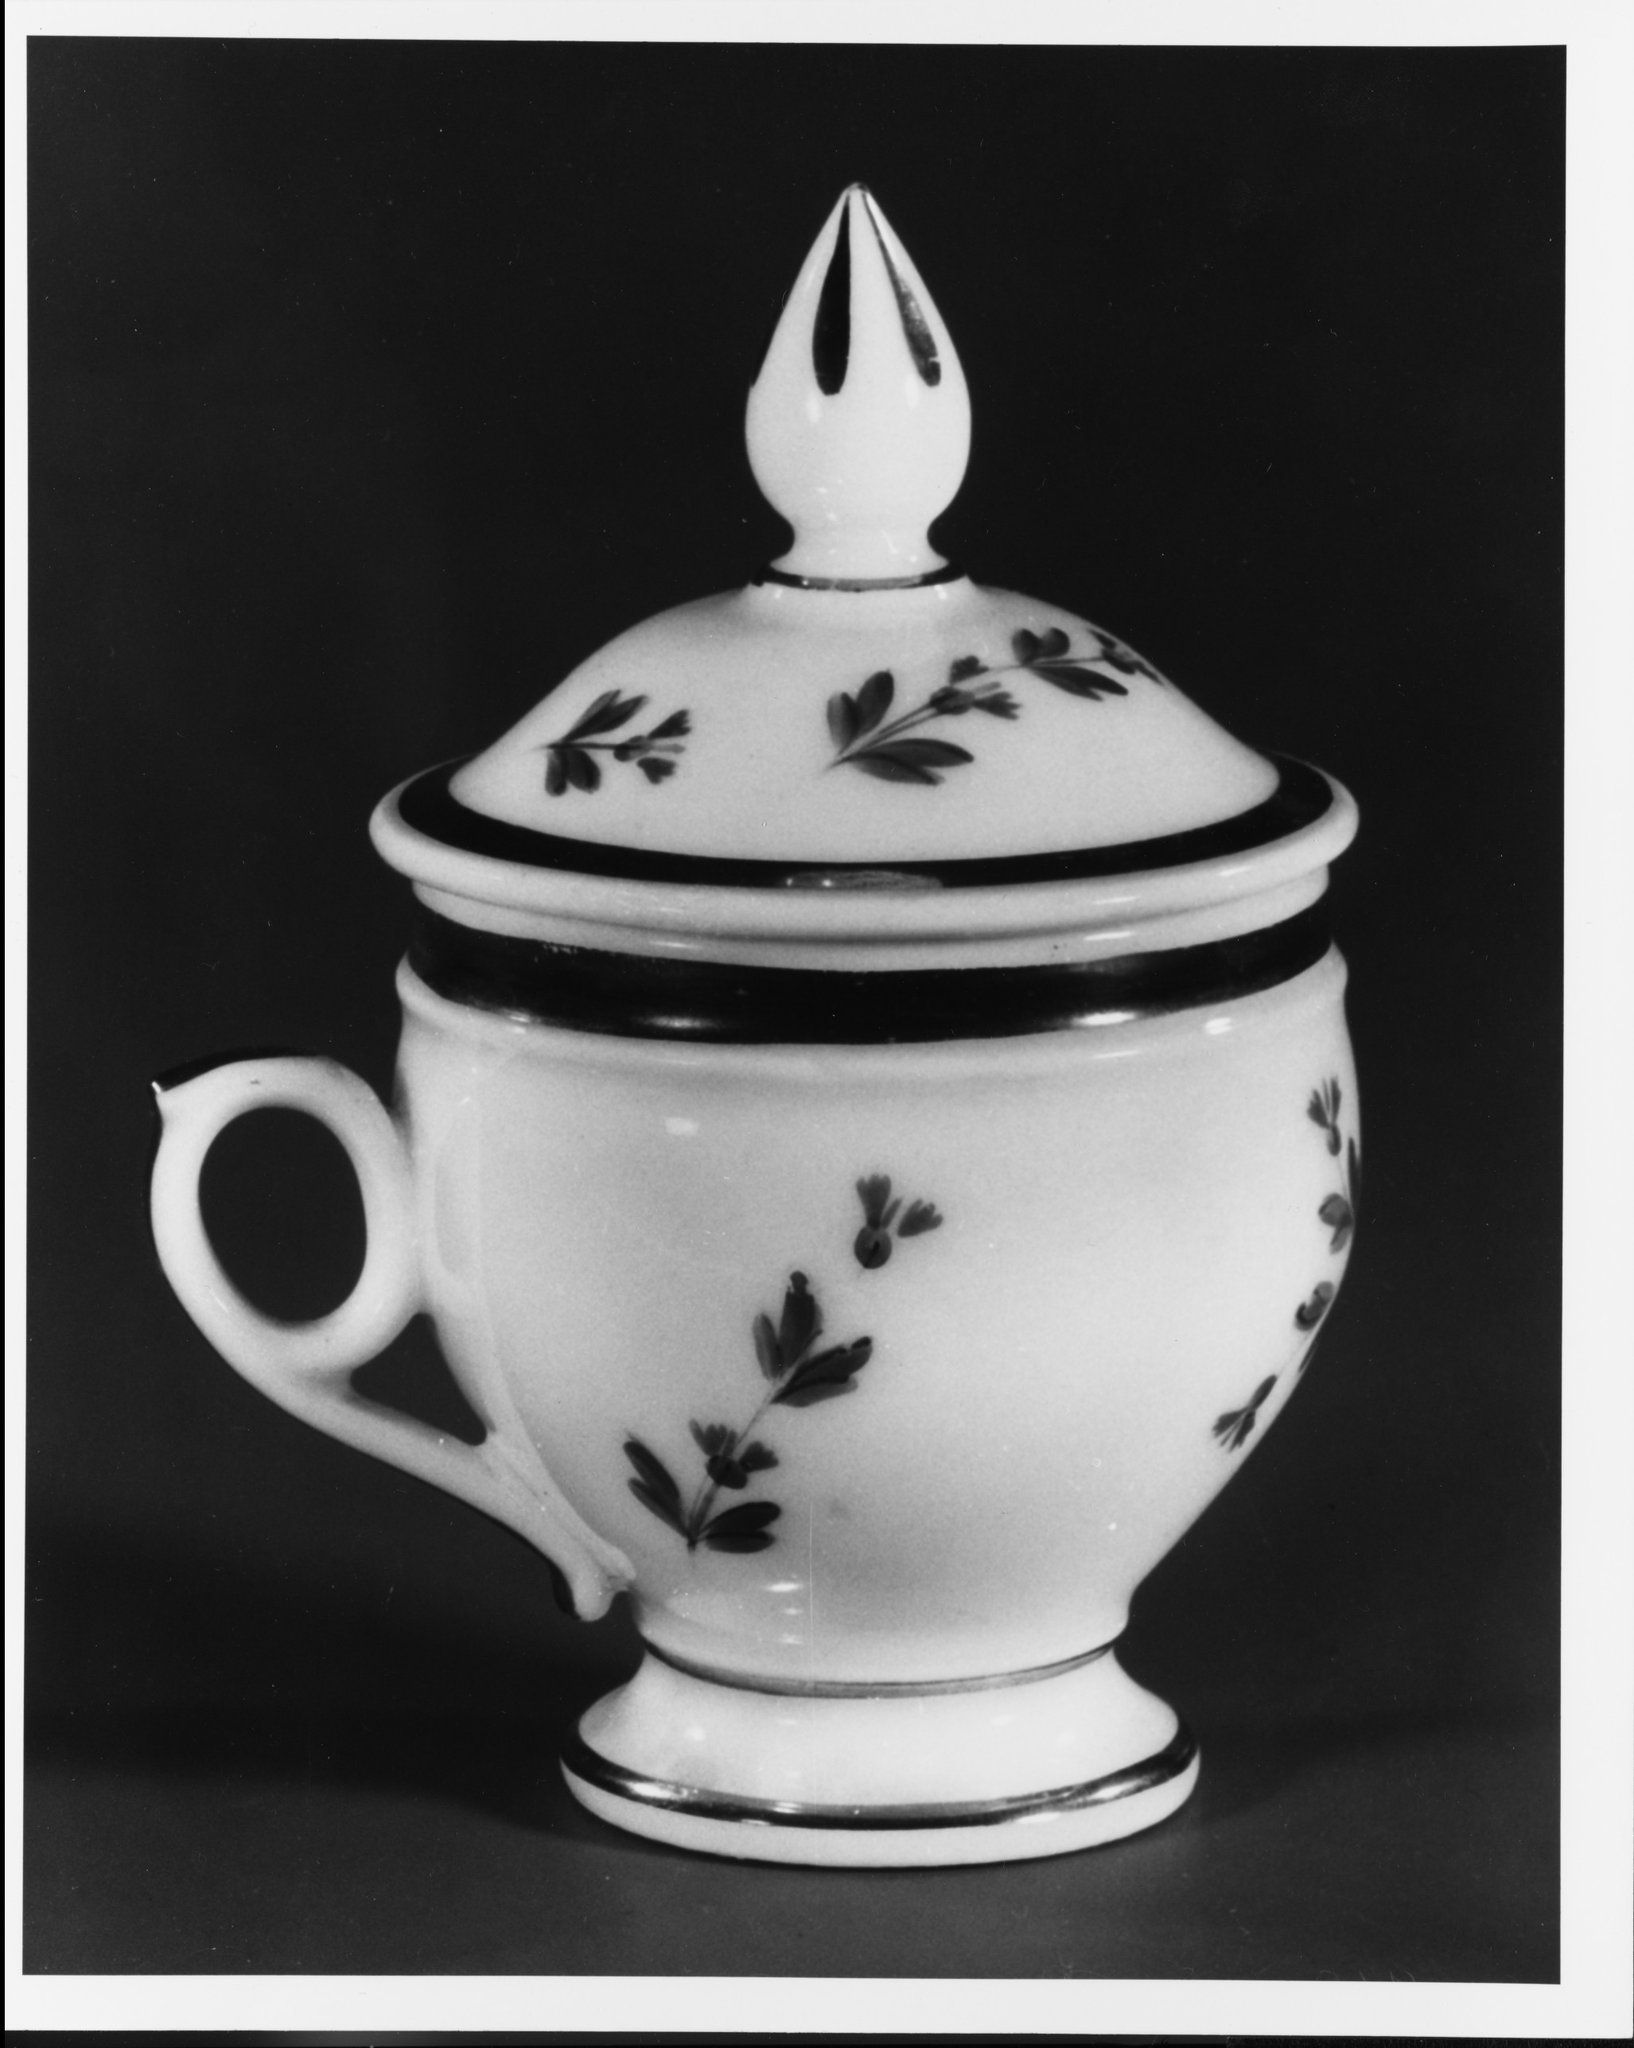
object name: custard cup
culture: french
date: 1815-1830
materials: porcelain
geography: france